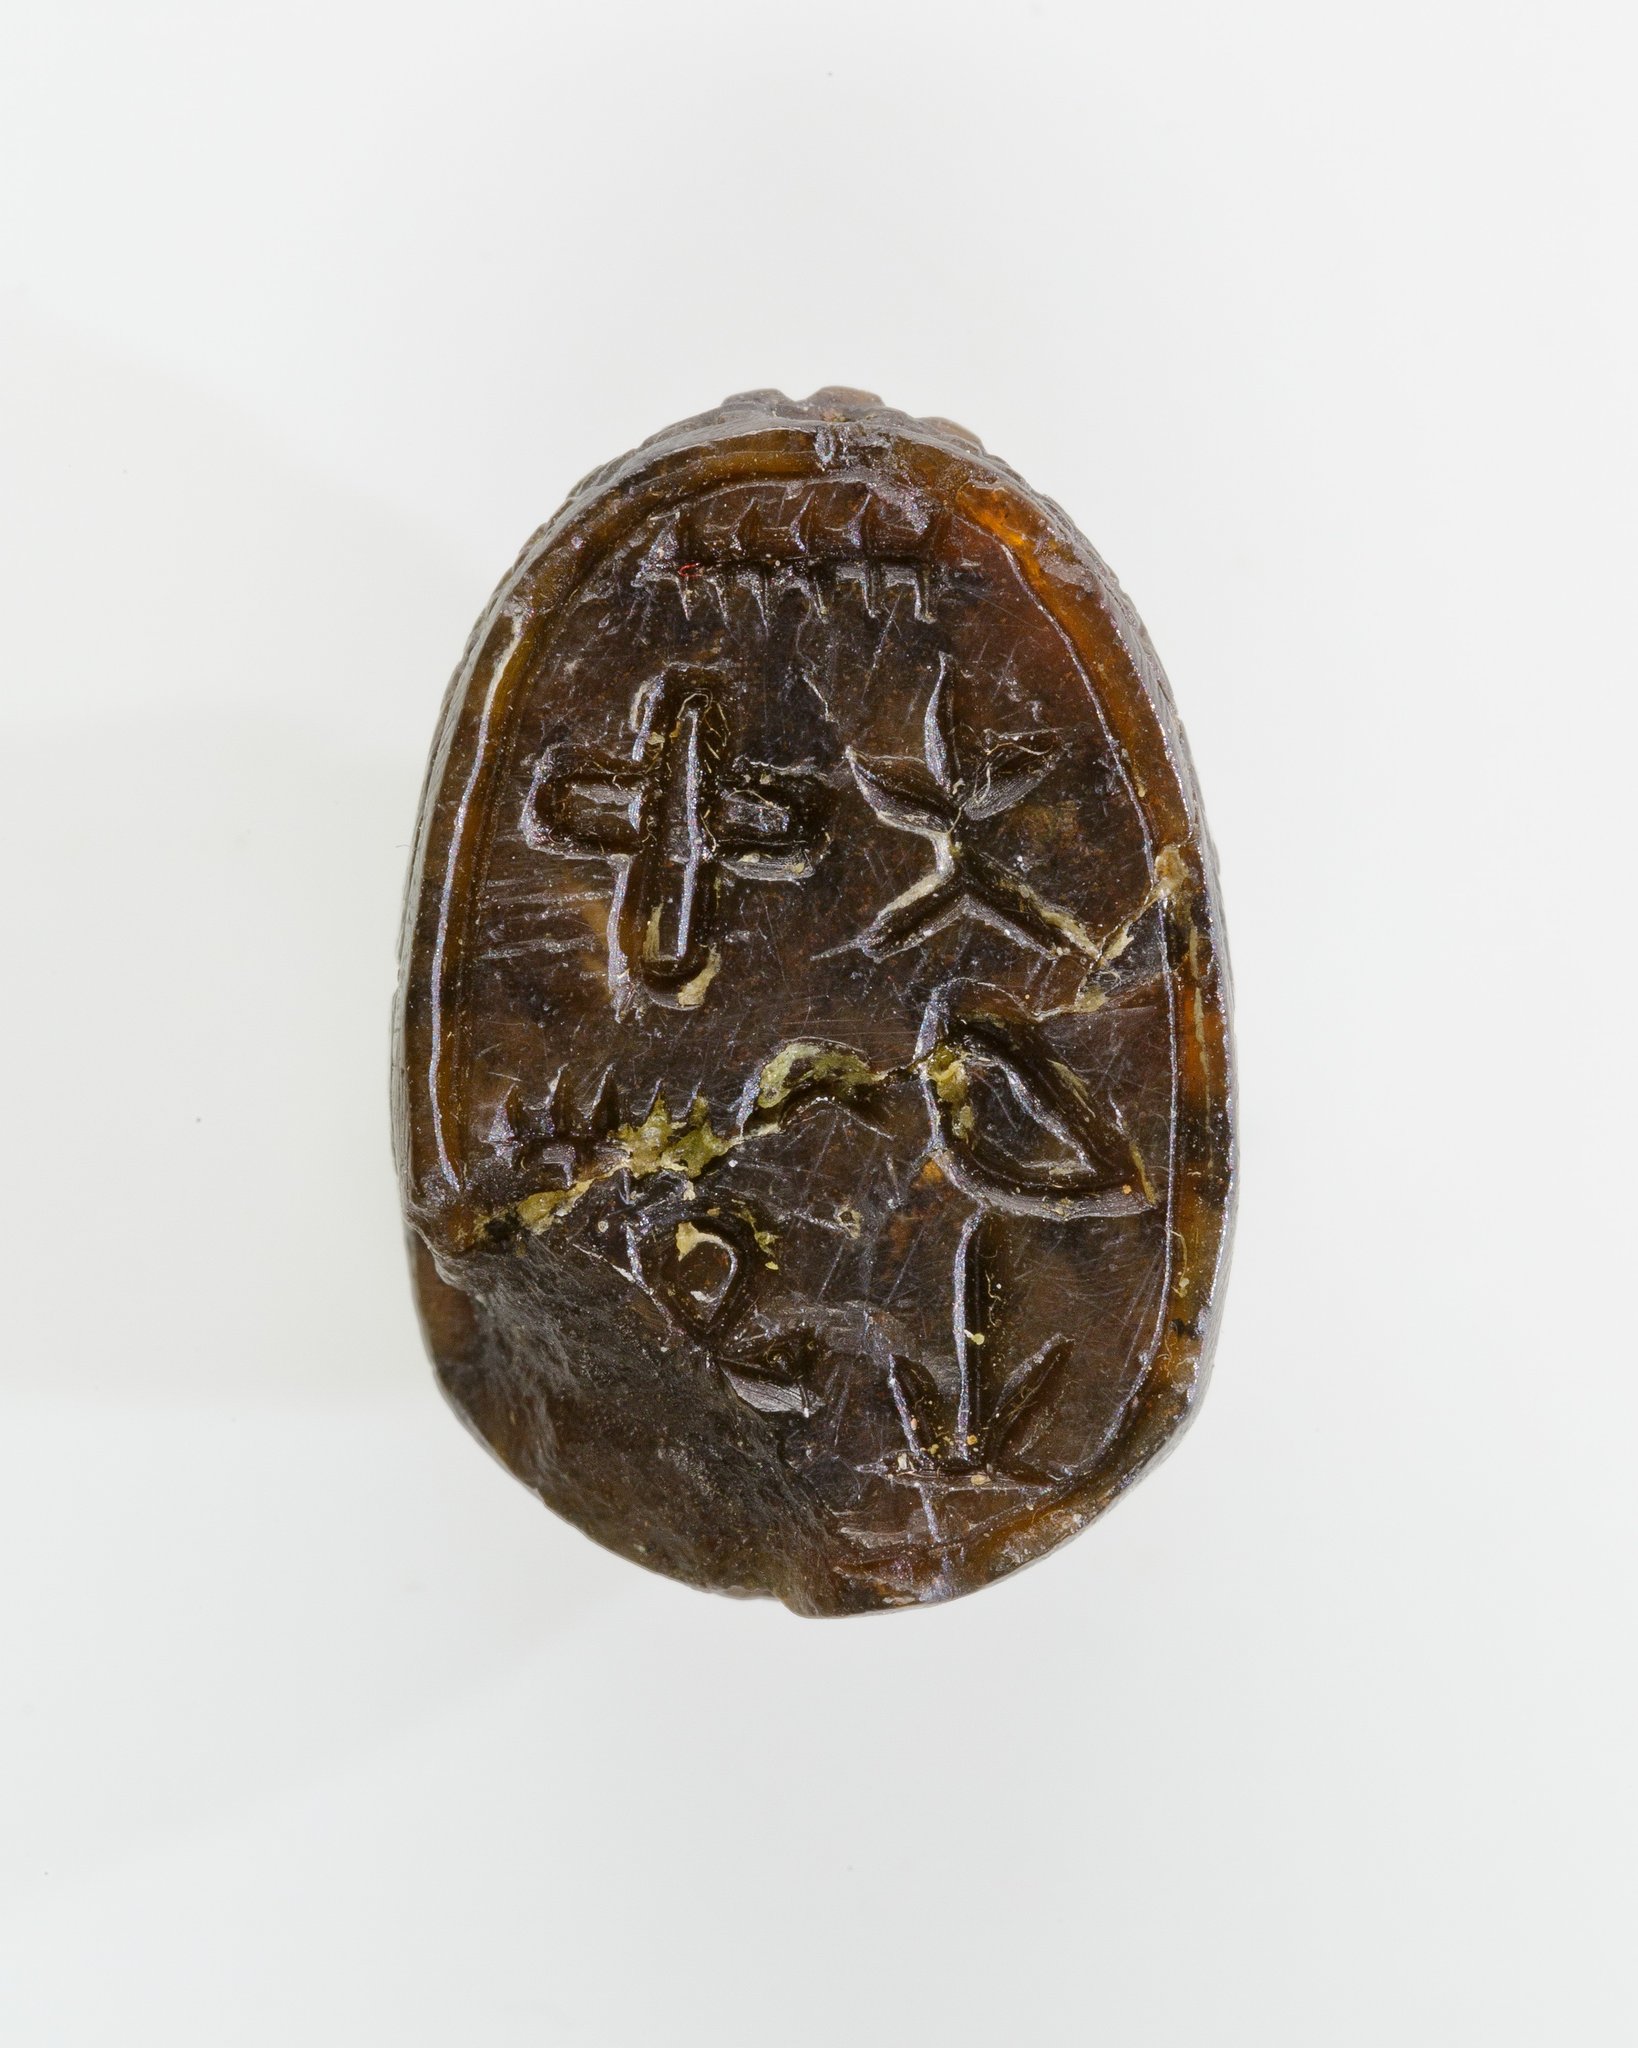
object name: scarab, private name and title, official, astronomer, ankh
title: Scarab of an Official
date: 1760-1670 BCE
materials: stone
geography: egypt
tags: scarabs